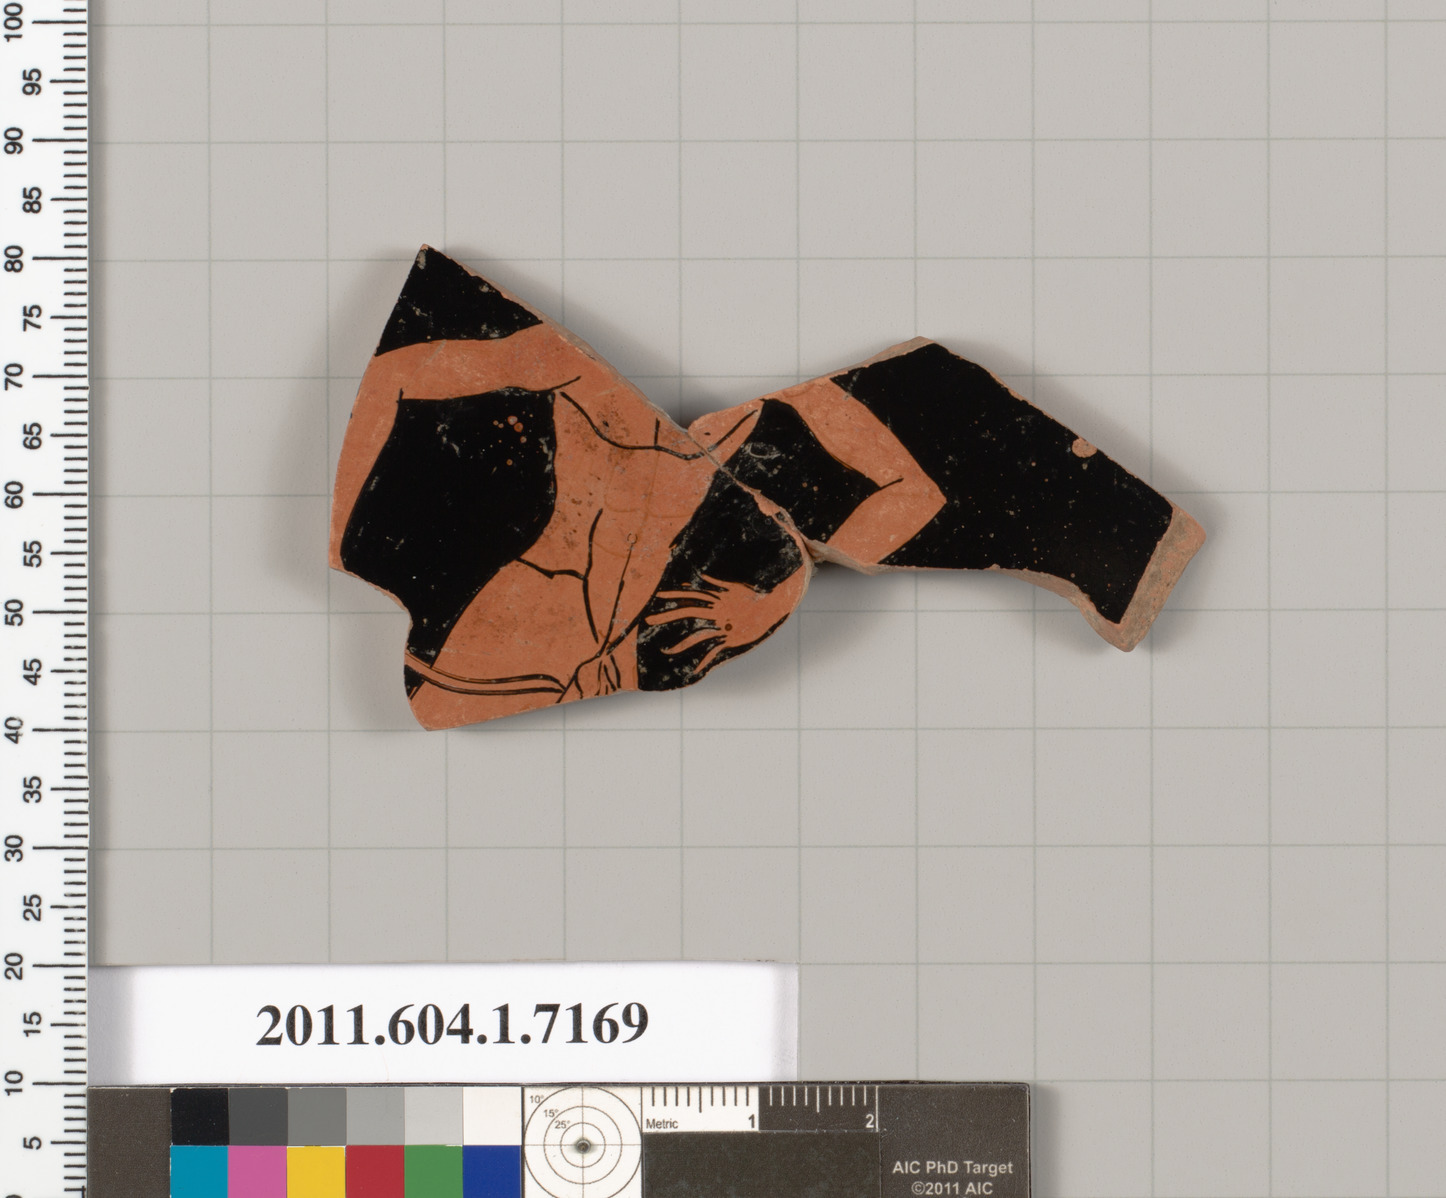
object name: kylix fragment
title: Terracotta fragment of a kylix (drinking cup)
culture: greek, attic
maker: makron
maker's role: artist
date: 500-480 BCE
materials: terracotta